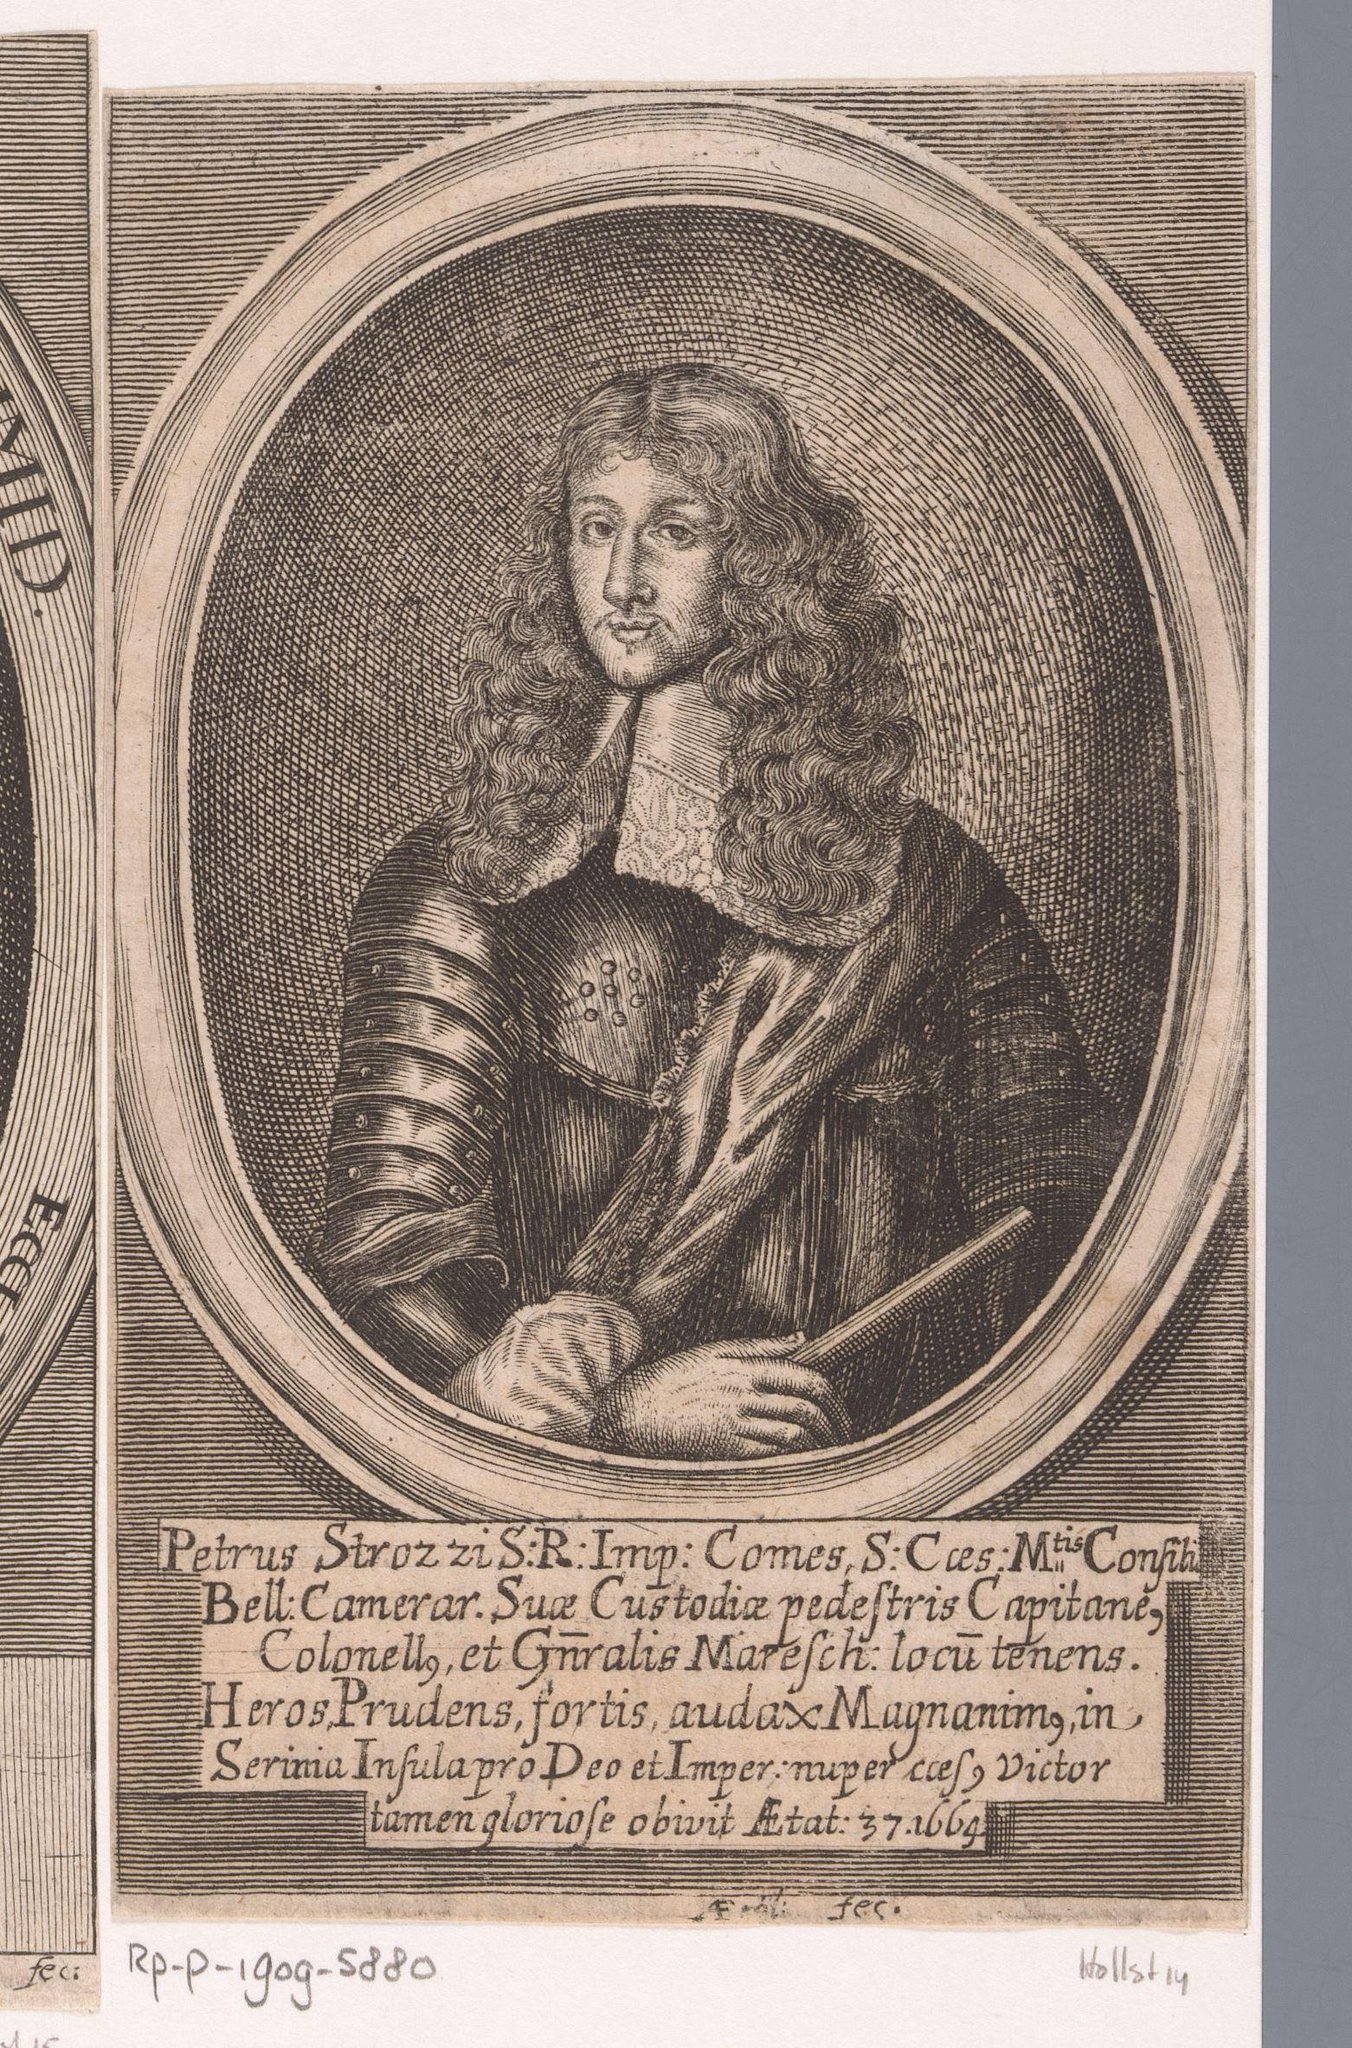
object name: print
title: Portret van Peter Strozzi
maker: andreas frölich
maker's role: print maker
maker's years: 1655-1671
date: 1669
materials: paper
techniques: engraving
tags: ornament ~ medallion, historical persons, baton of general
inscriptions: collector's mark: Lugt 2228